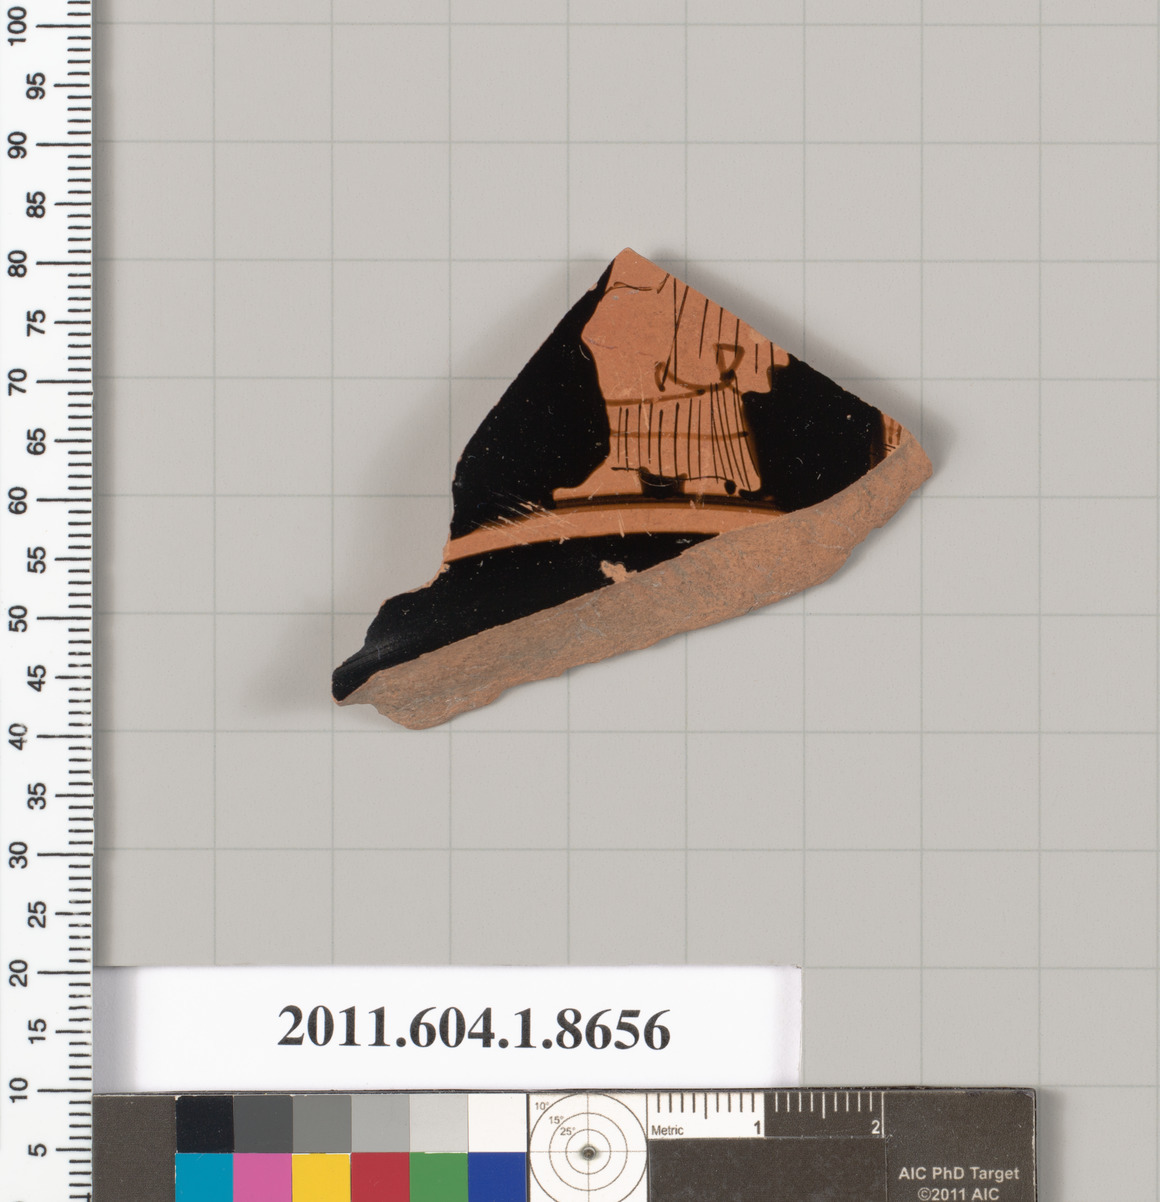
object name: kylix fragment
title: Terracotta rim fragment of a stemless? kylix (drinking cup)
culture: greek, attic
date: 460-450 BCE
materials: terracotta